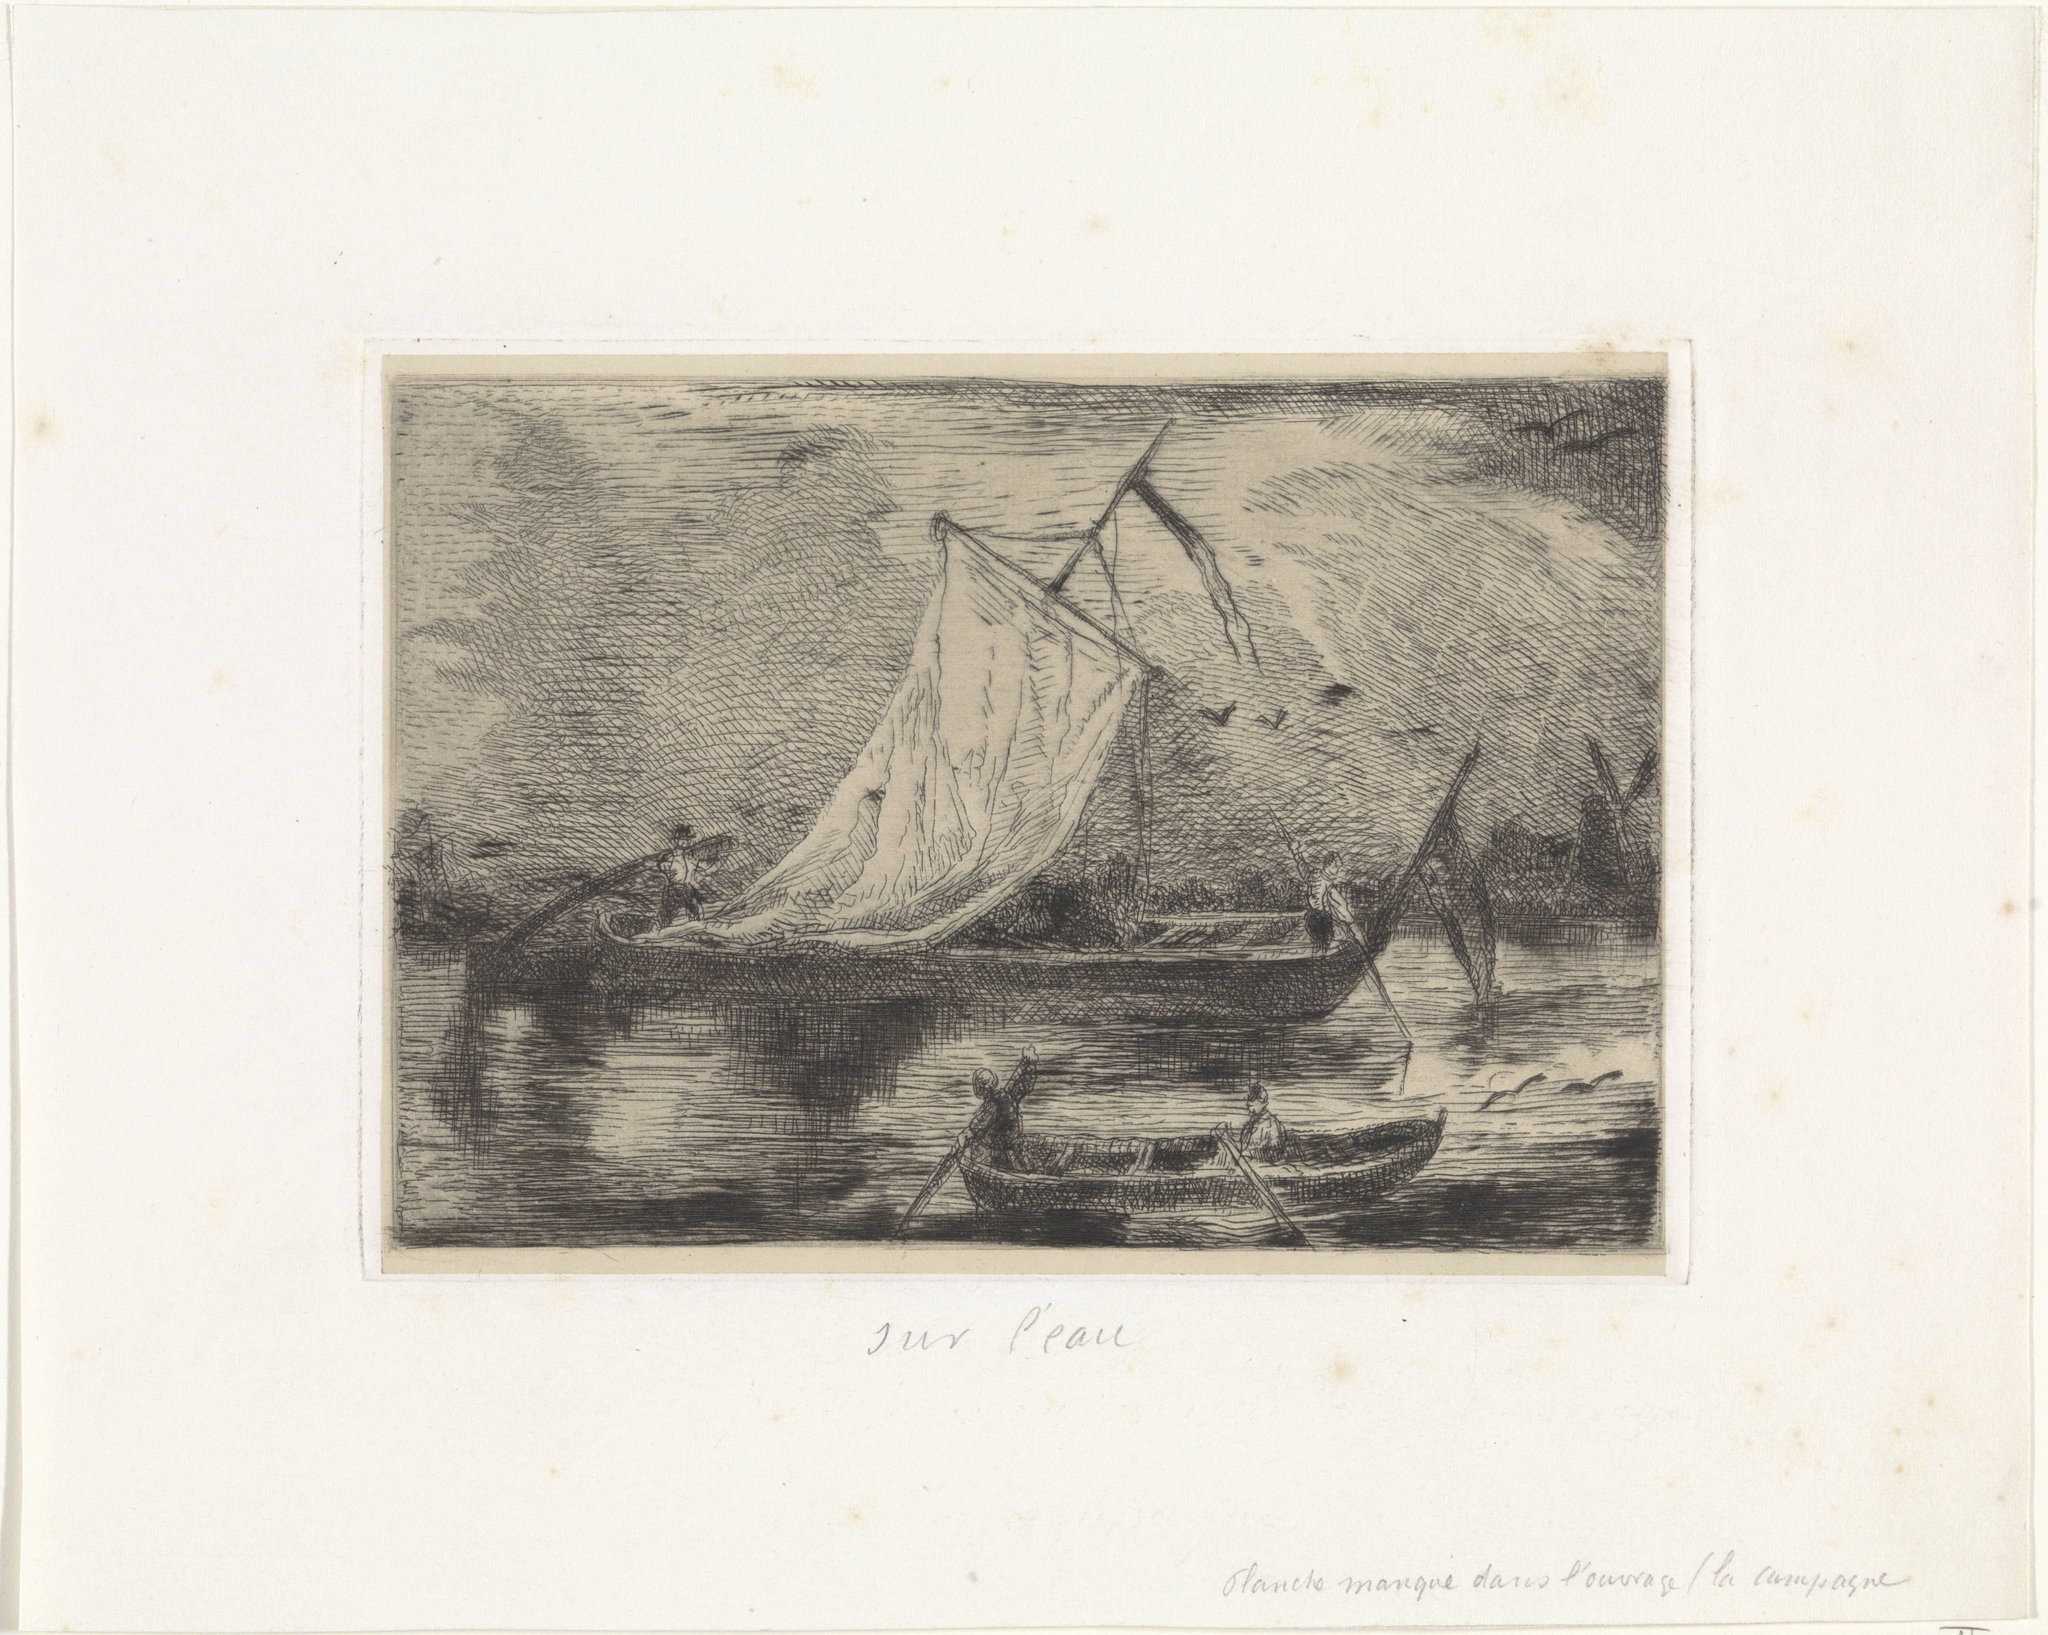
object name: print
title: Boten op het water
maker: arnoud schaepkens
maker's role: print maker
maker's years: 1816-1904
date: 1855-1904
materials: paper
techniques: drypoint, etching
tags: landscapes with waters, waterscapes, seascapes (in the temperate zone), rowing-boat, canoe, etc.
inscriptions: collector's mark: Lugt 2228